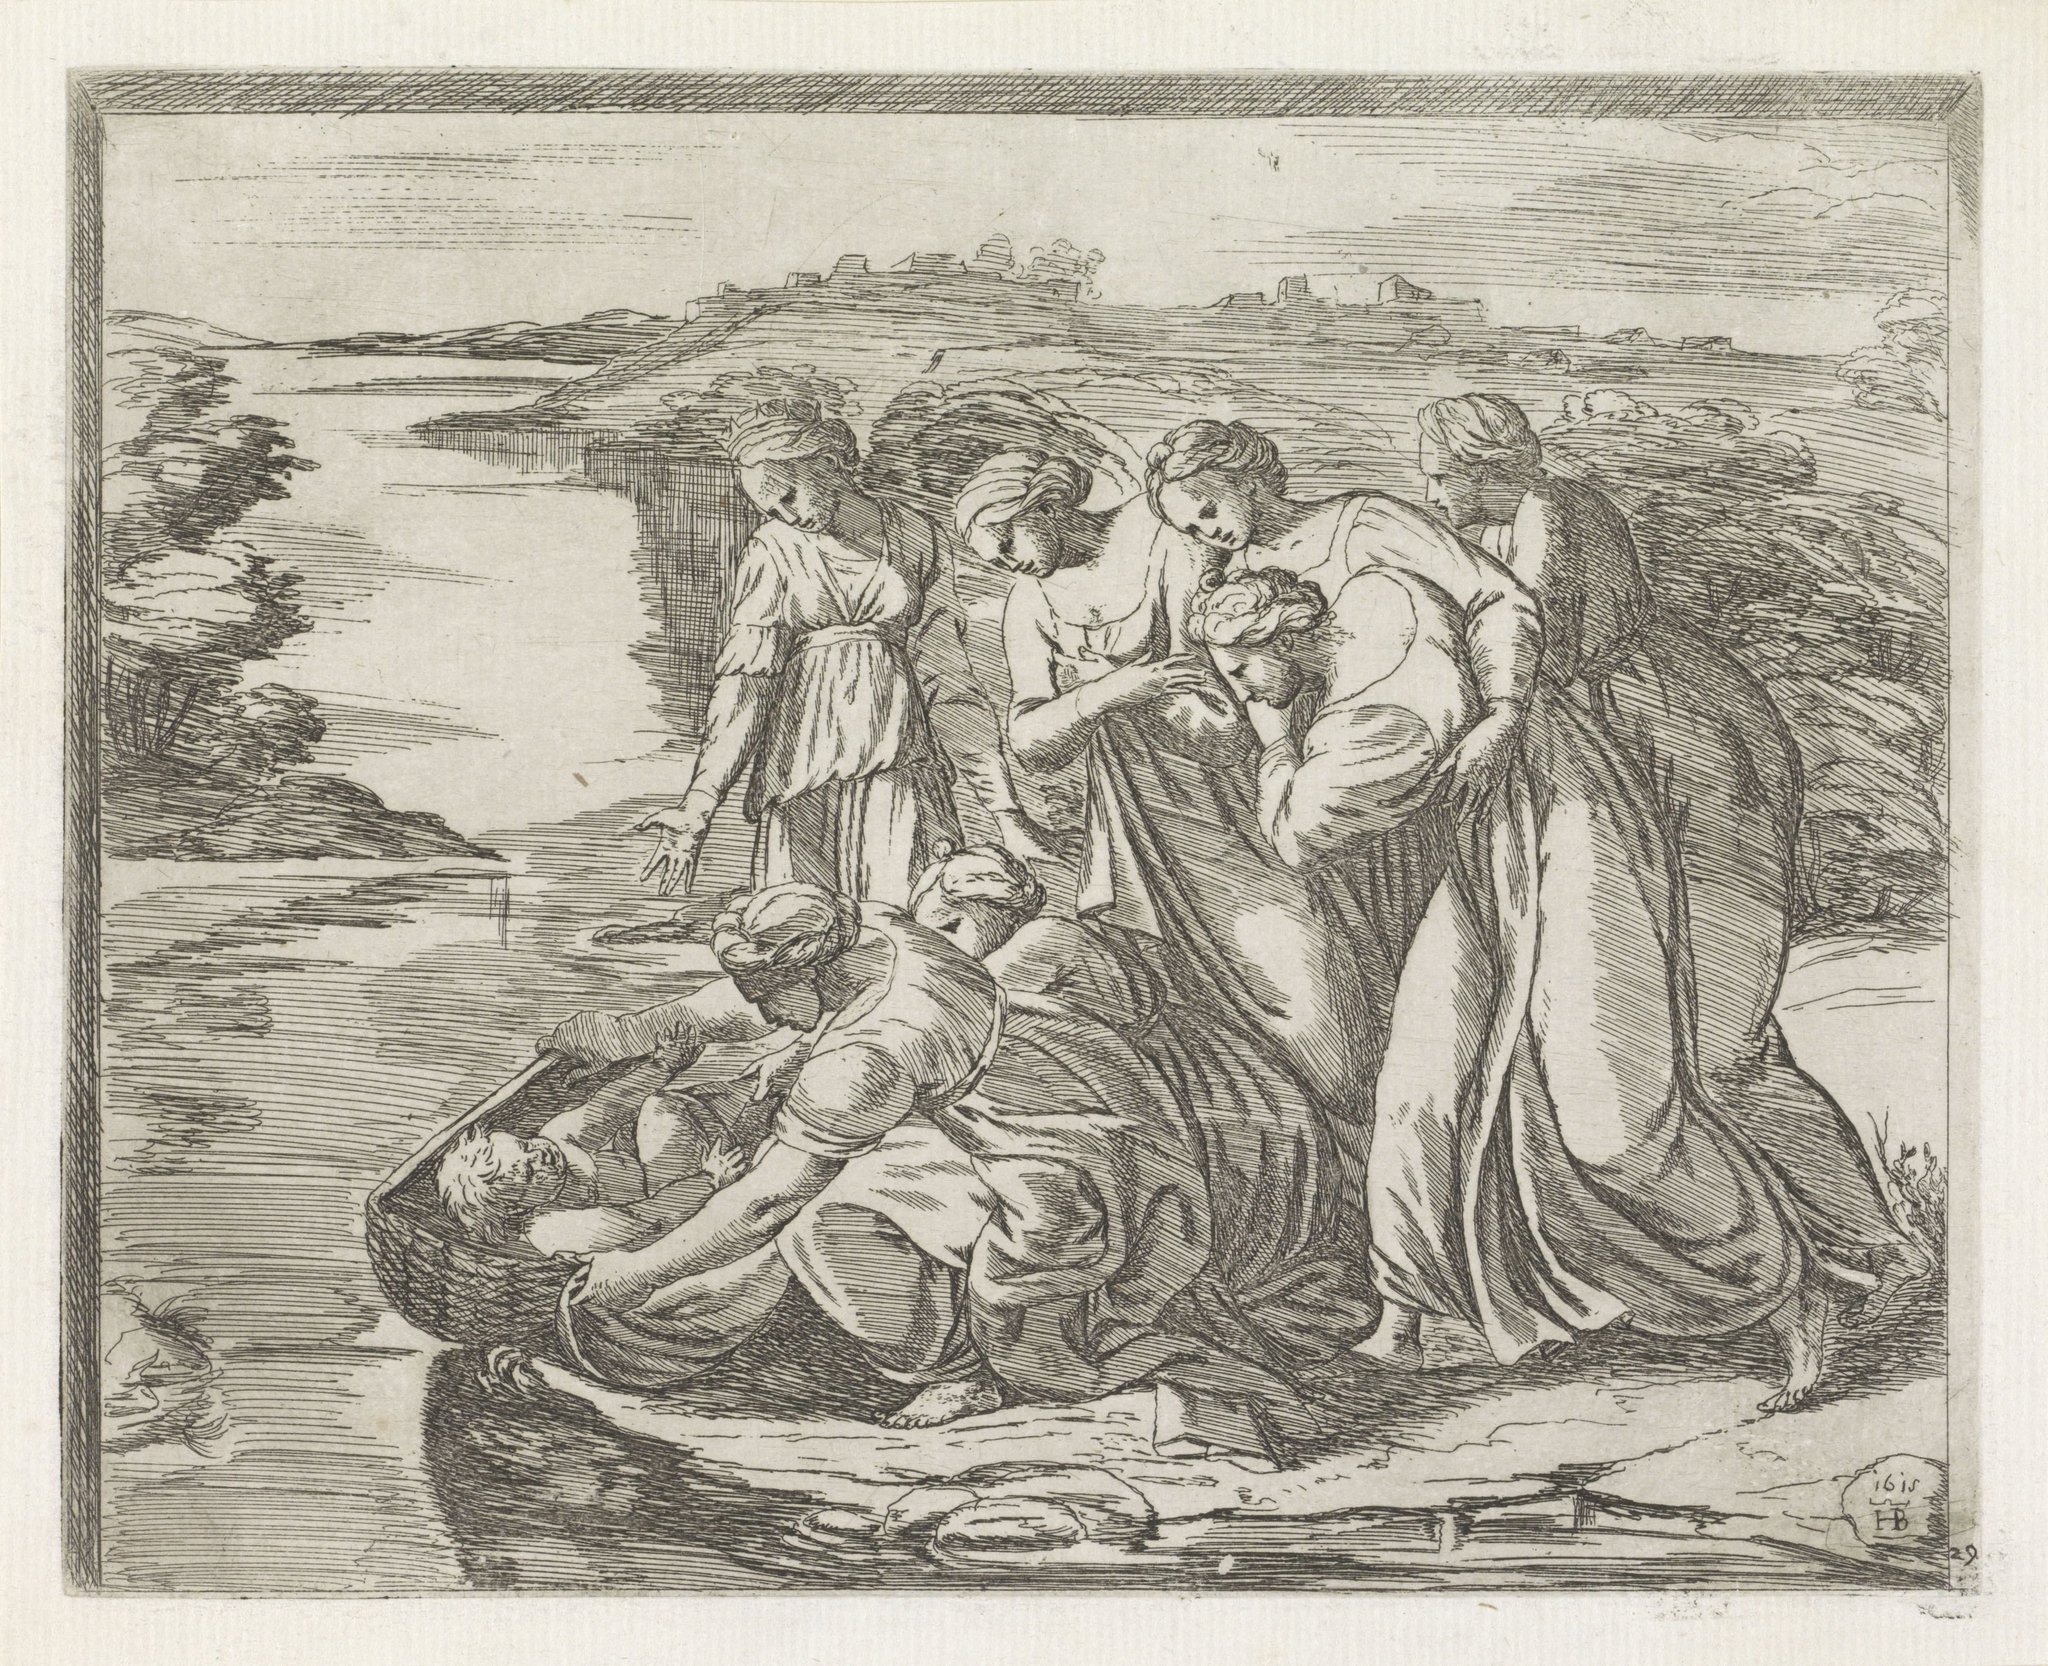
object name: print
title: Schilderingen in de Loggia van Rafaël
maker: orazio borgianni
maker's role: print maker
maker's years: 1578-1616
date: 1615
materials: paper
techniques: etching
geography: italy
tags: the finding of moses: pharaoh's daughter comes to bathe with her maidens in the river and discovers the child floating on the water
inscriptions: collector's mark: Lugt 2165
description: Mozes wordt in een mandje op de rivier gevonden door de dochter van farao en haar dienstmaagden. Een van de vrouwen trekt het mandje naar zich toe.